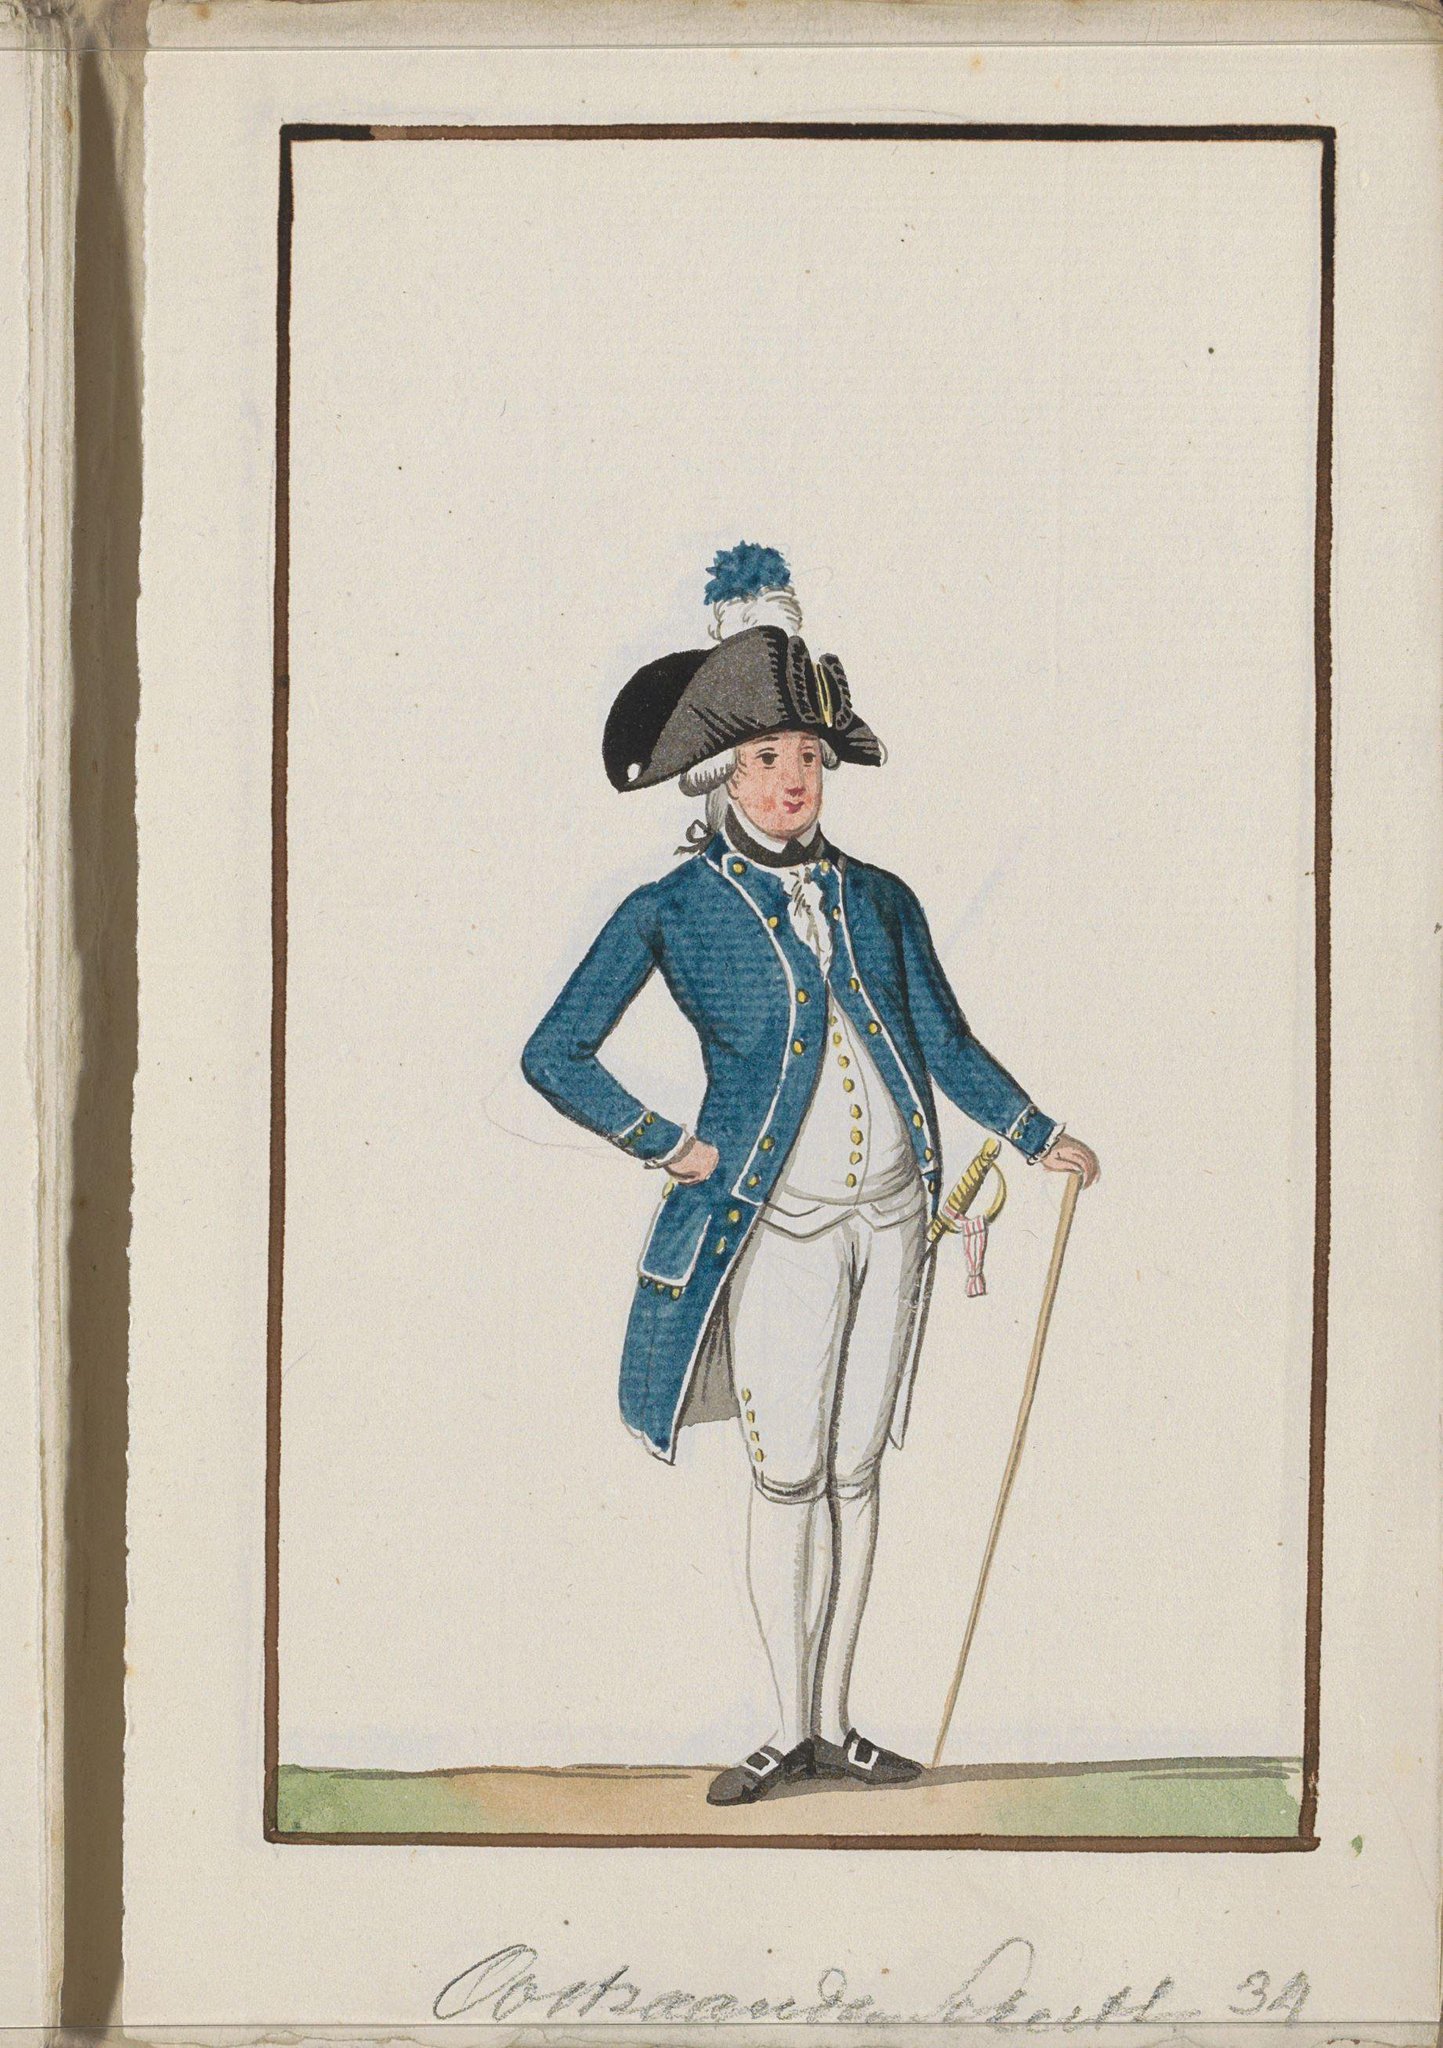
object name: drawing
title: Montering van de schutterij van Oostzaandam, ca. 1785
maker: Anonymous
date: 1789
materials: paper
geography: northern netherlands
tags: (military) uniforms (+ citizen soldiery, civil guard, citizen militia), patriots (1780-1795)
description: Montering of uniform van de schutterij van Oostzaandam, ca. 1785. Onderdeel van een schetsboek met 41 gekleurde tekeningen van de monteringen van de gewapende schutterijen en burgercorpsen in Nederland in de periode ca. 1783-1789.